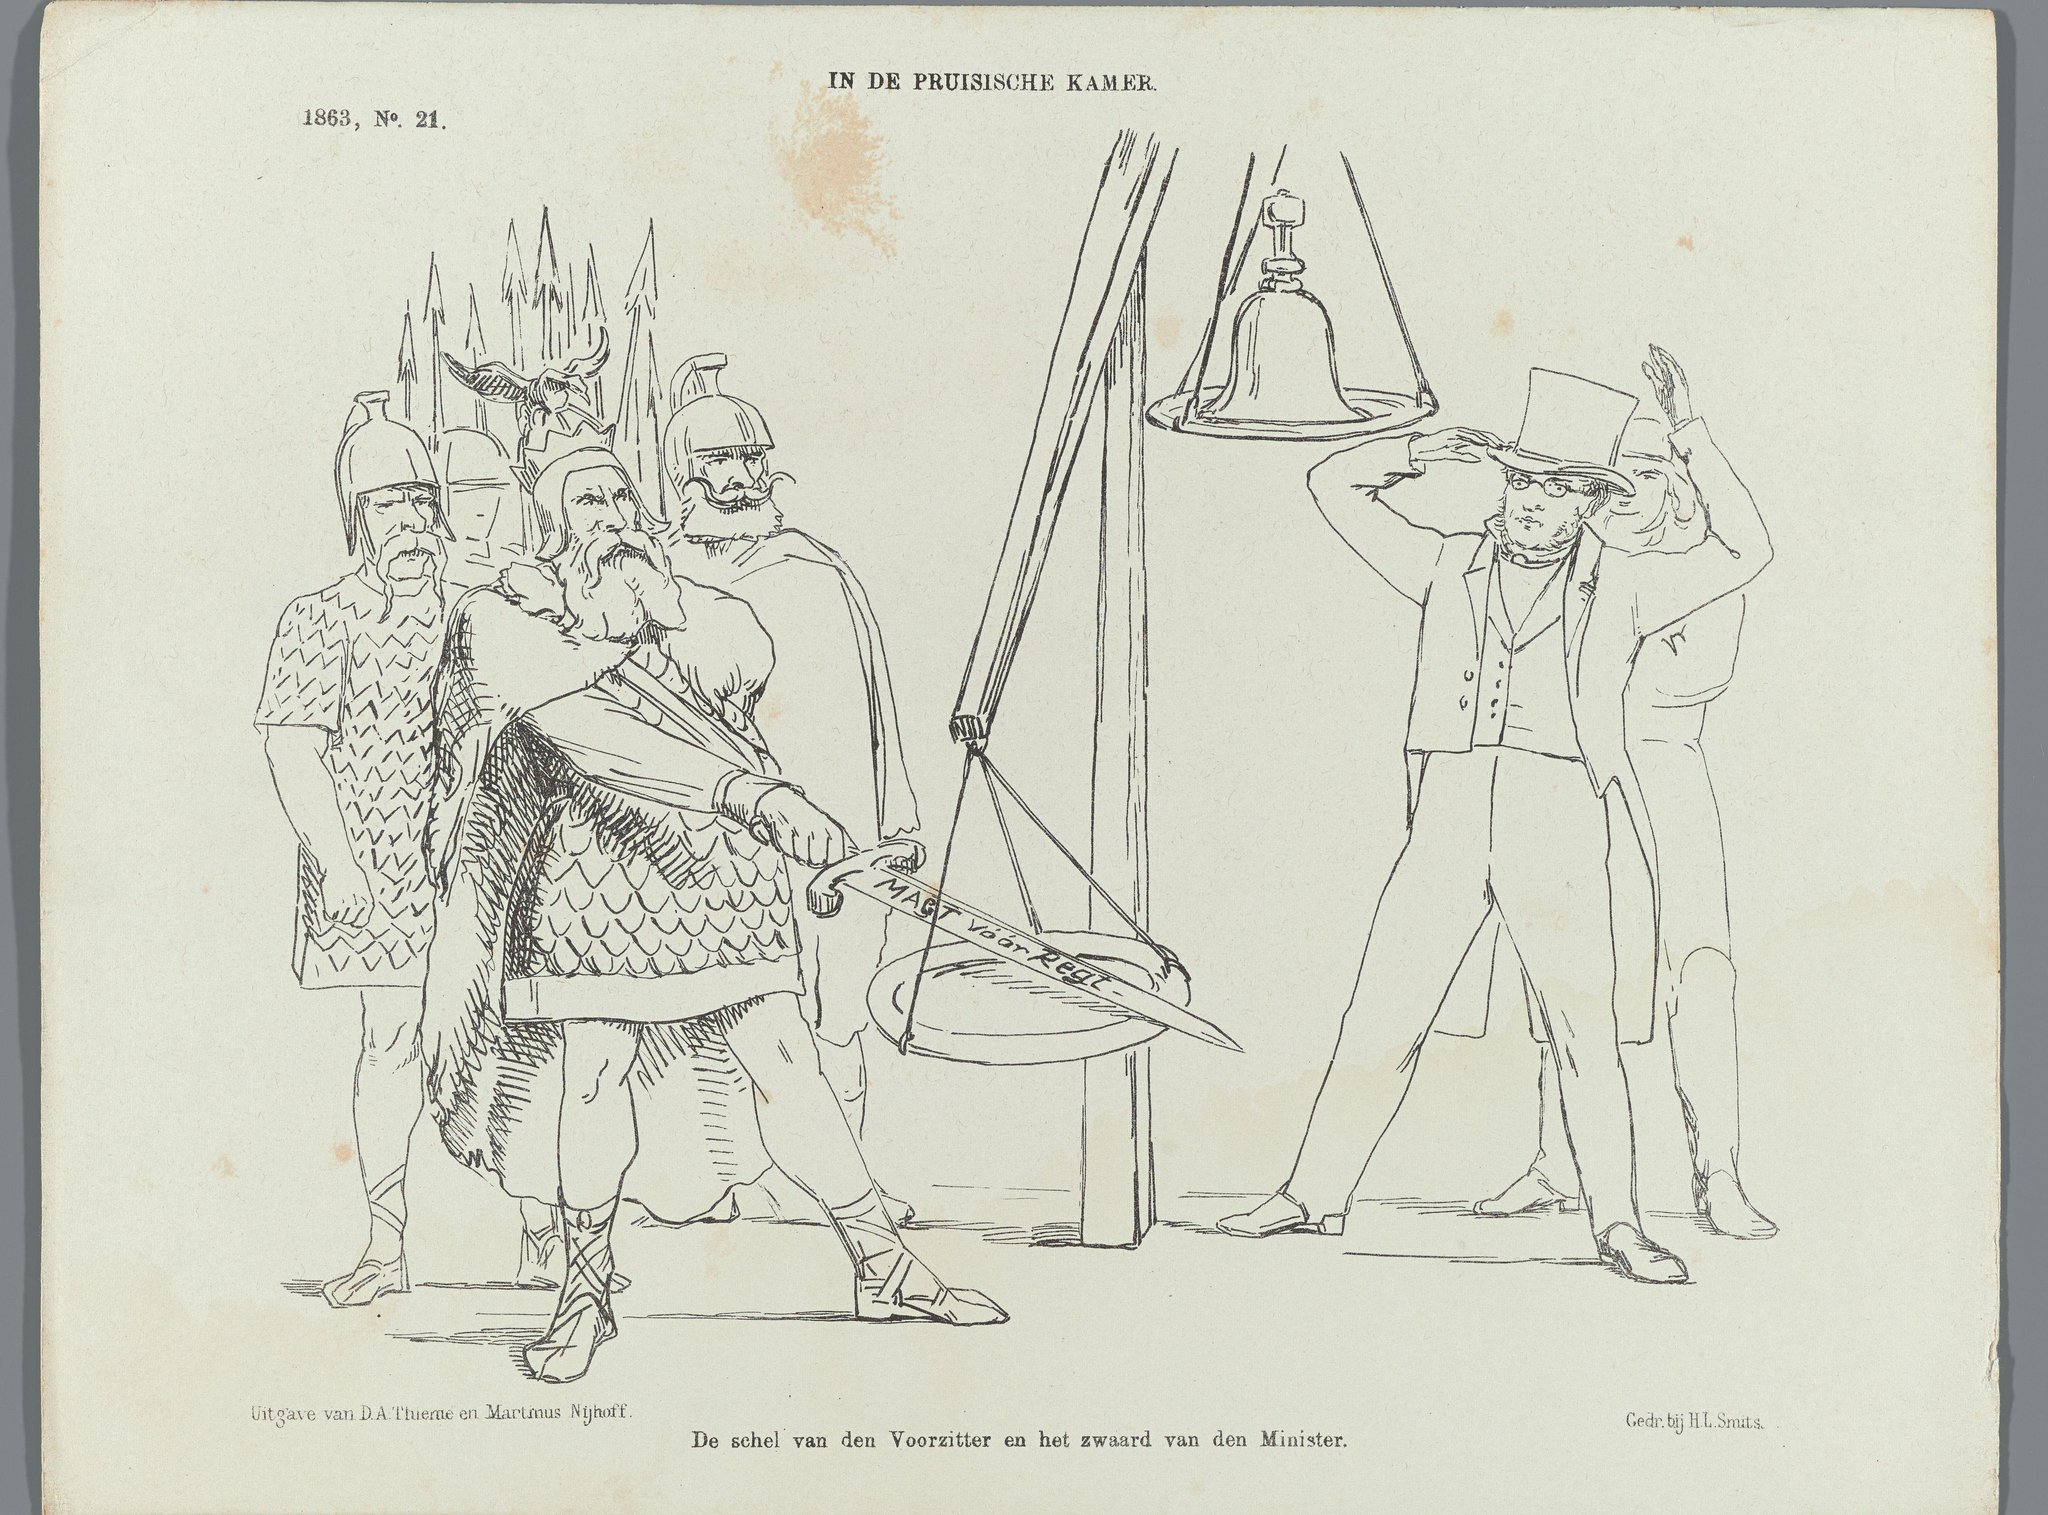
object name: cartoon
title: Spotprent over de Pruisische politiek, 1863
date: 1863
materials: paper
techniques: lithograph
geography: arnhem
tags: scales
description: Spotprent over de Pruisische politiek. Een Germaan legt zijn zwaard 'Magt vóór Regt' op de weegschaal. Plaat verschenen bij het weekblad De Nederlandsche Spectator, nr. 21, 23 mei 1863.